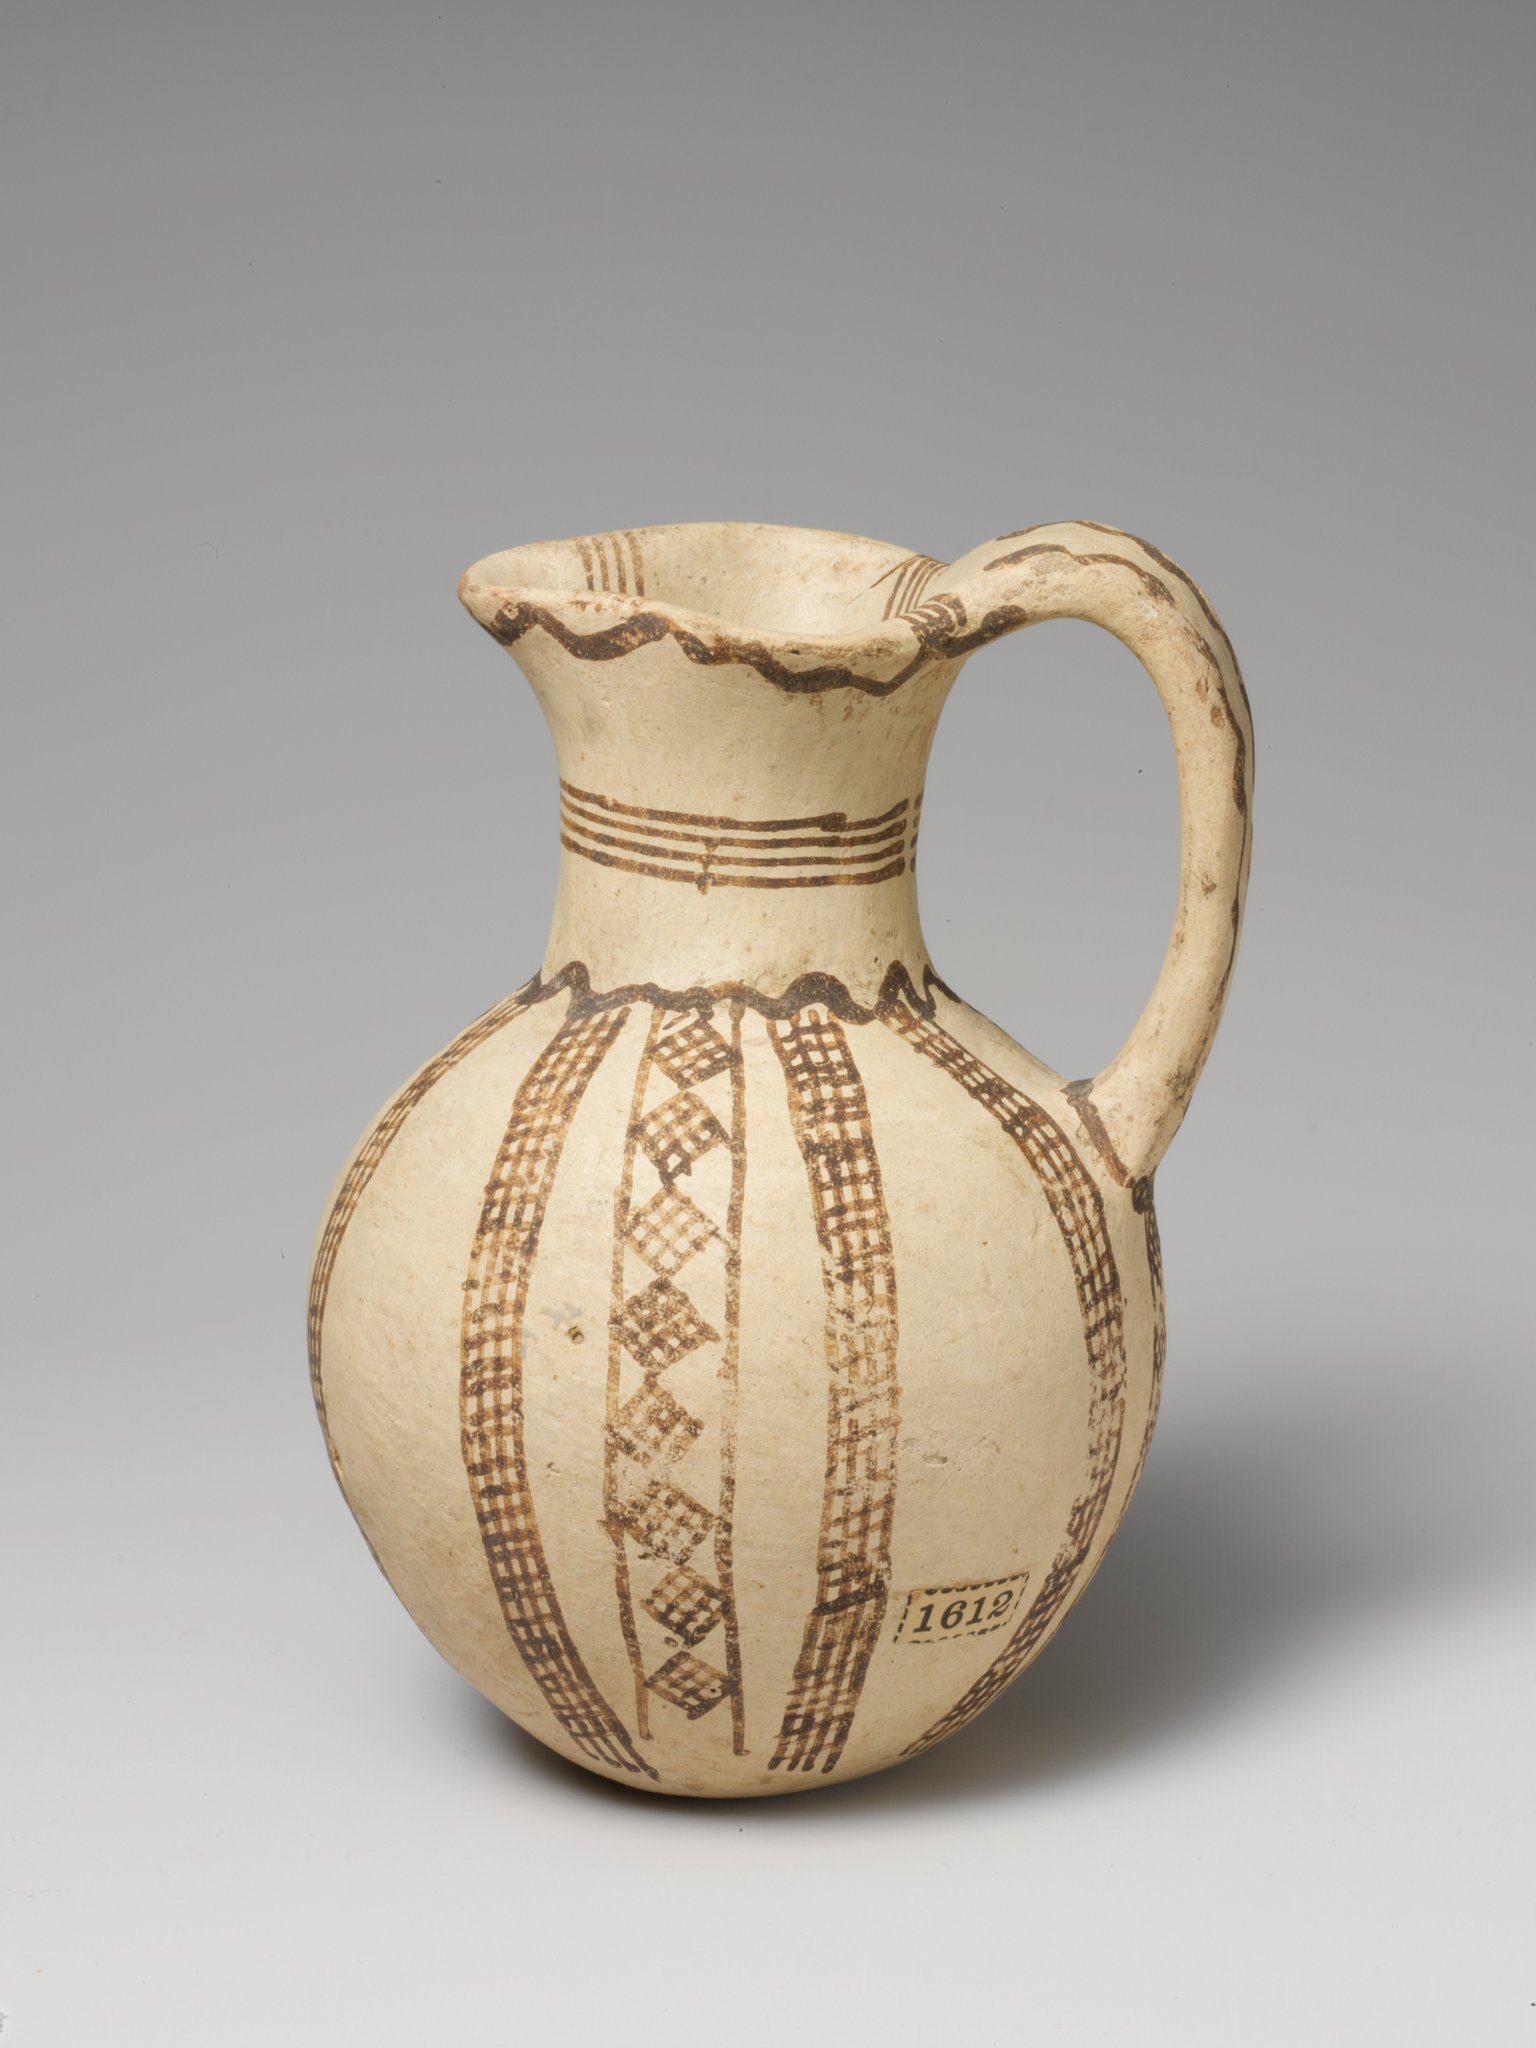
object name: juglet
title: Terracotta juglet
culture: cypriot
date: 1600-1150 BCE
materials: terracotta